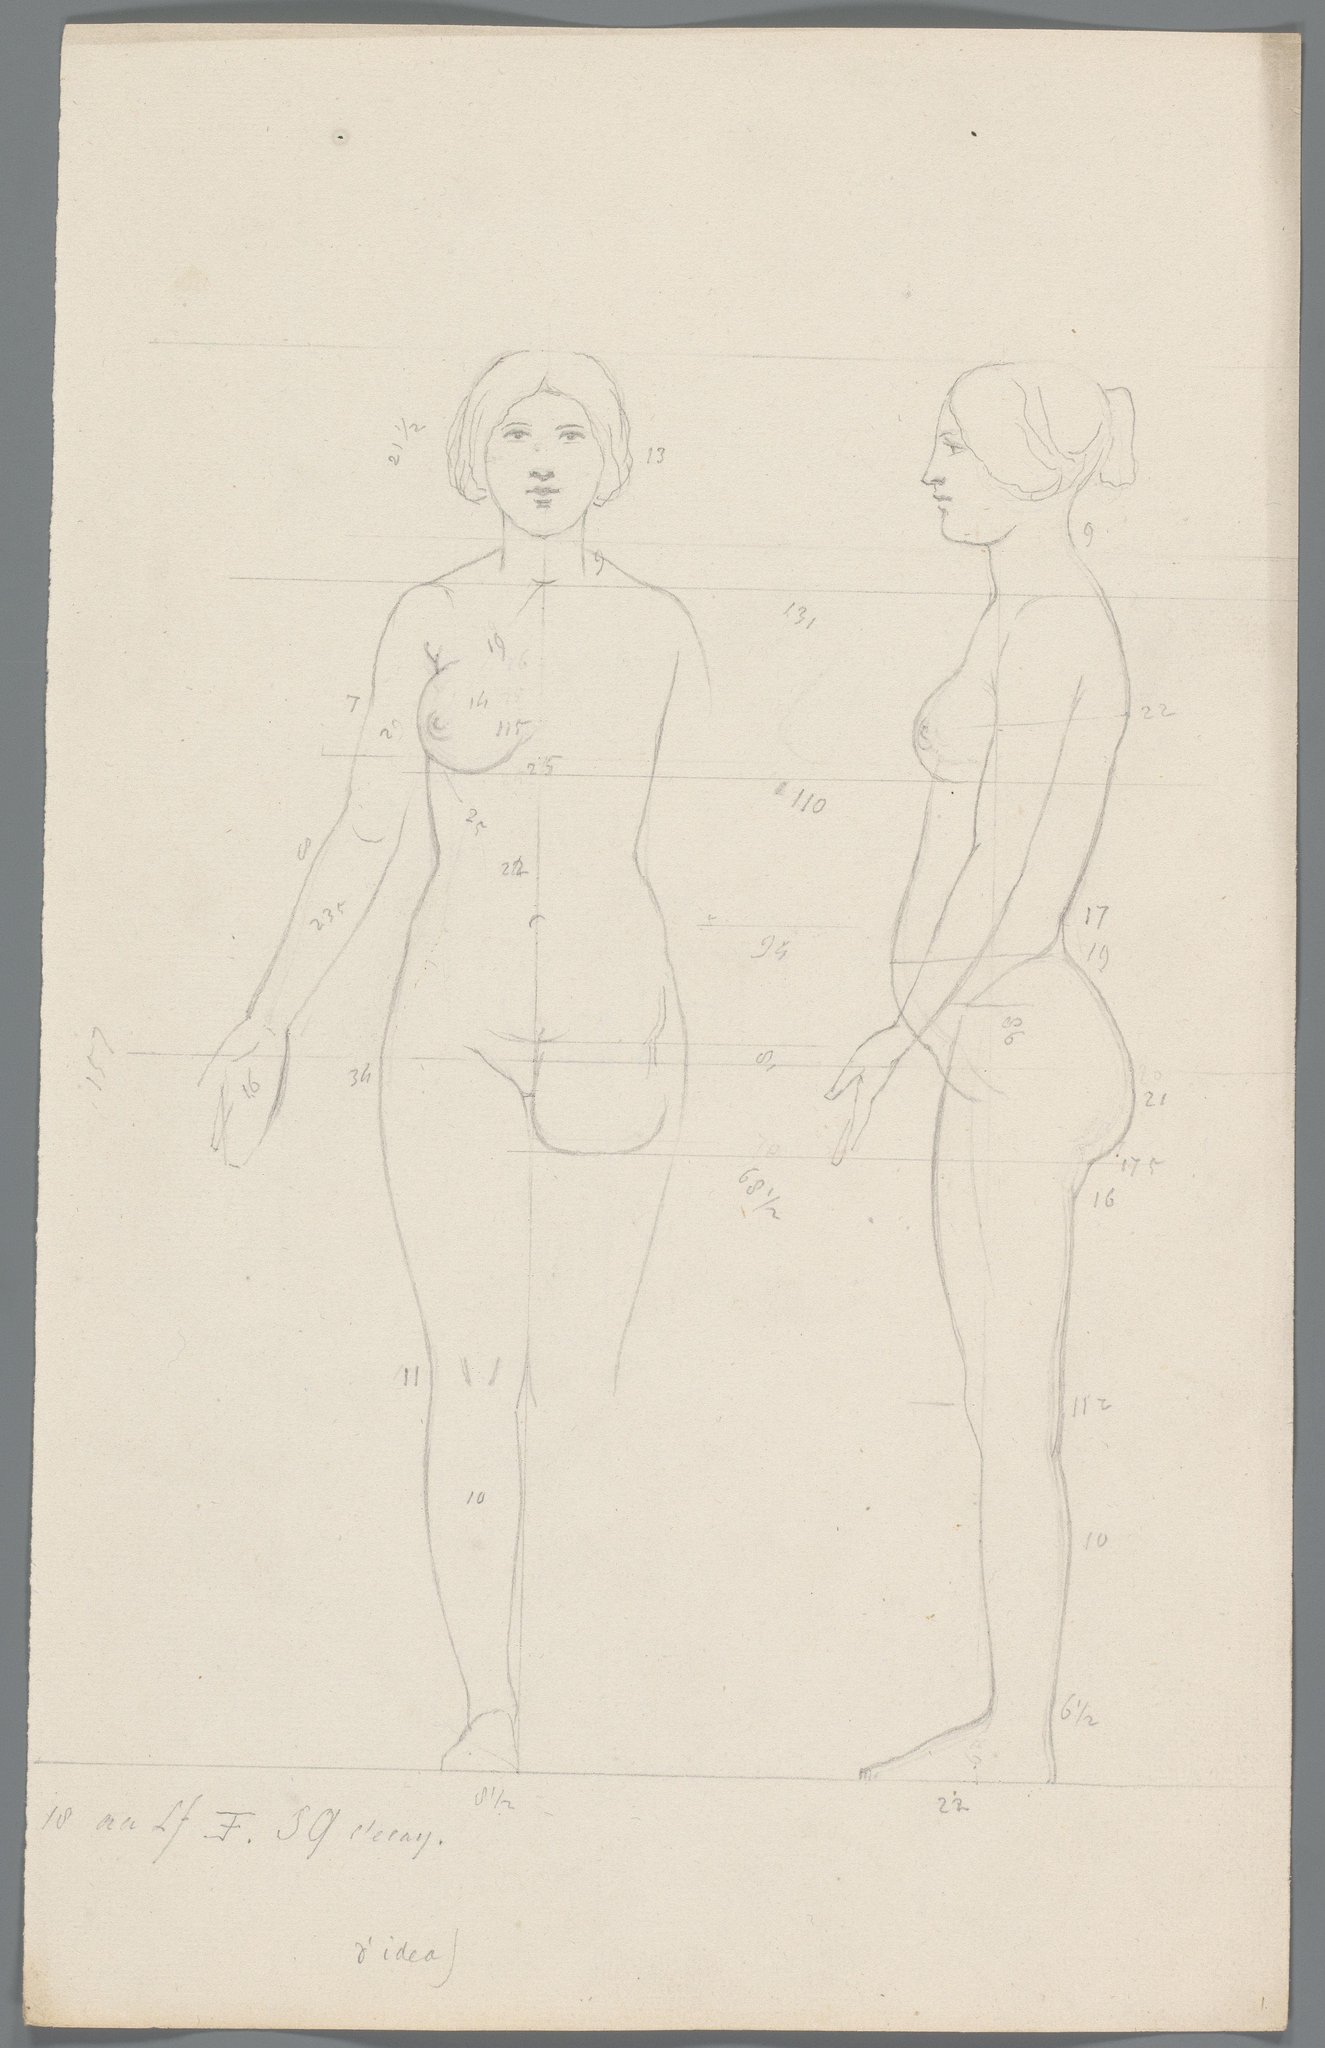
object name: drawing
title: Proportiestudie van een vrouw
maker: jacobus everhardus josephus van den berg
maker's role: draughtsman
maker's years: 1802-1861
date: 1856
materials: paper, pencil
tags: standing figure (canon, proportions) - aa - female human figure, anatomy (non-medical) - aa - female human figure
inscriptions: inscription: ‘18 aa Lf EG Sq c'ecay/ d'idea’